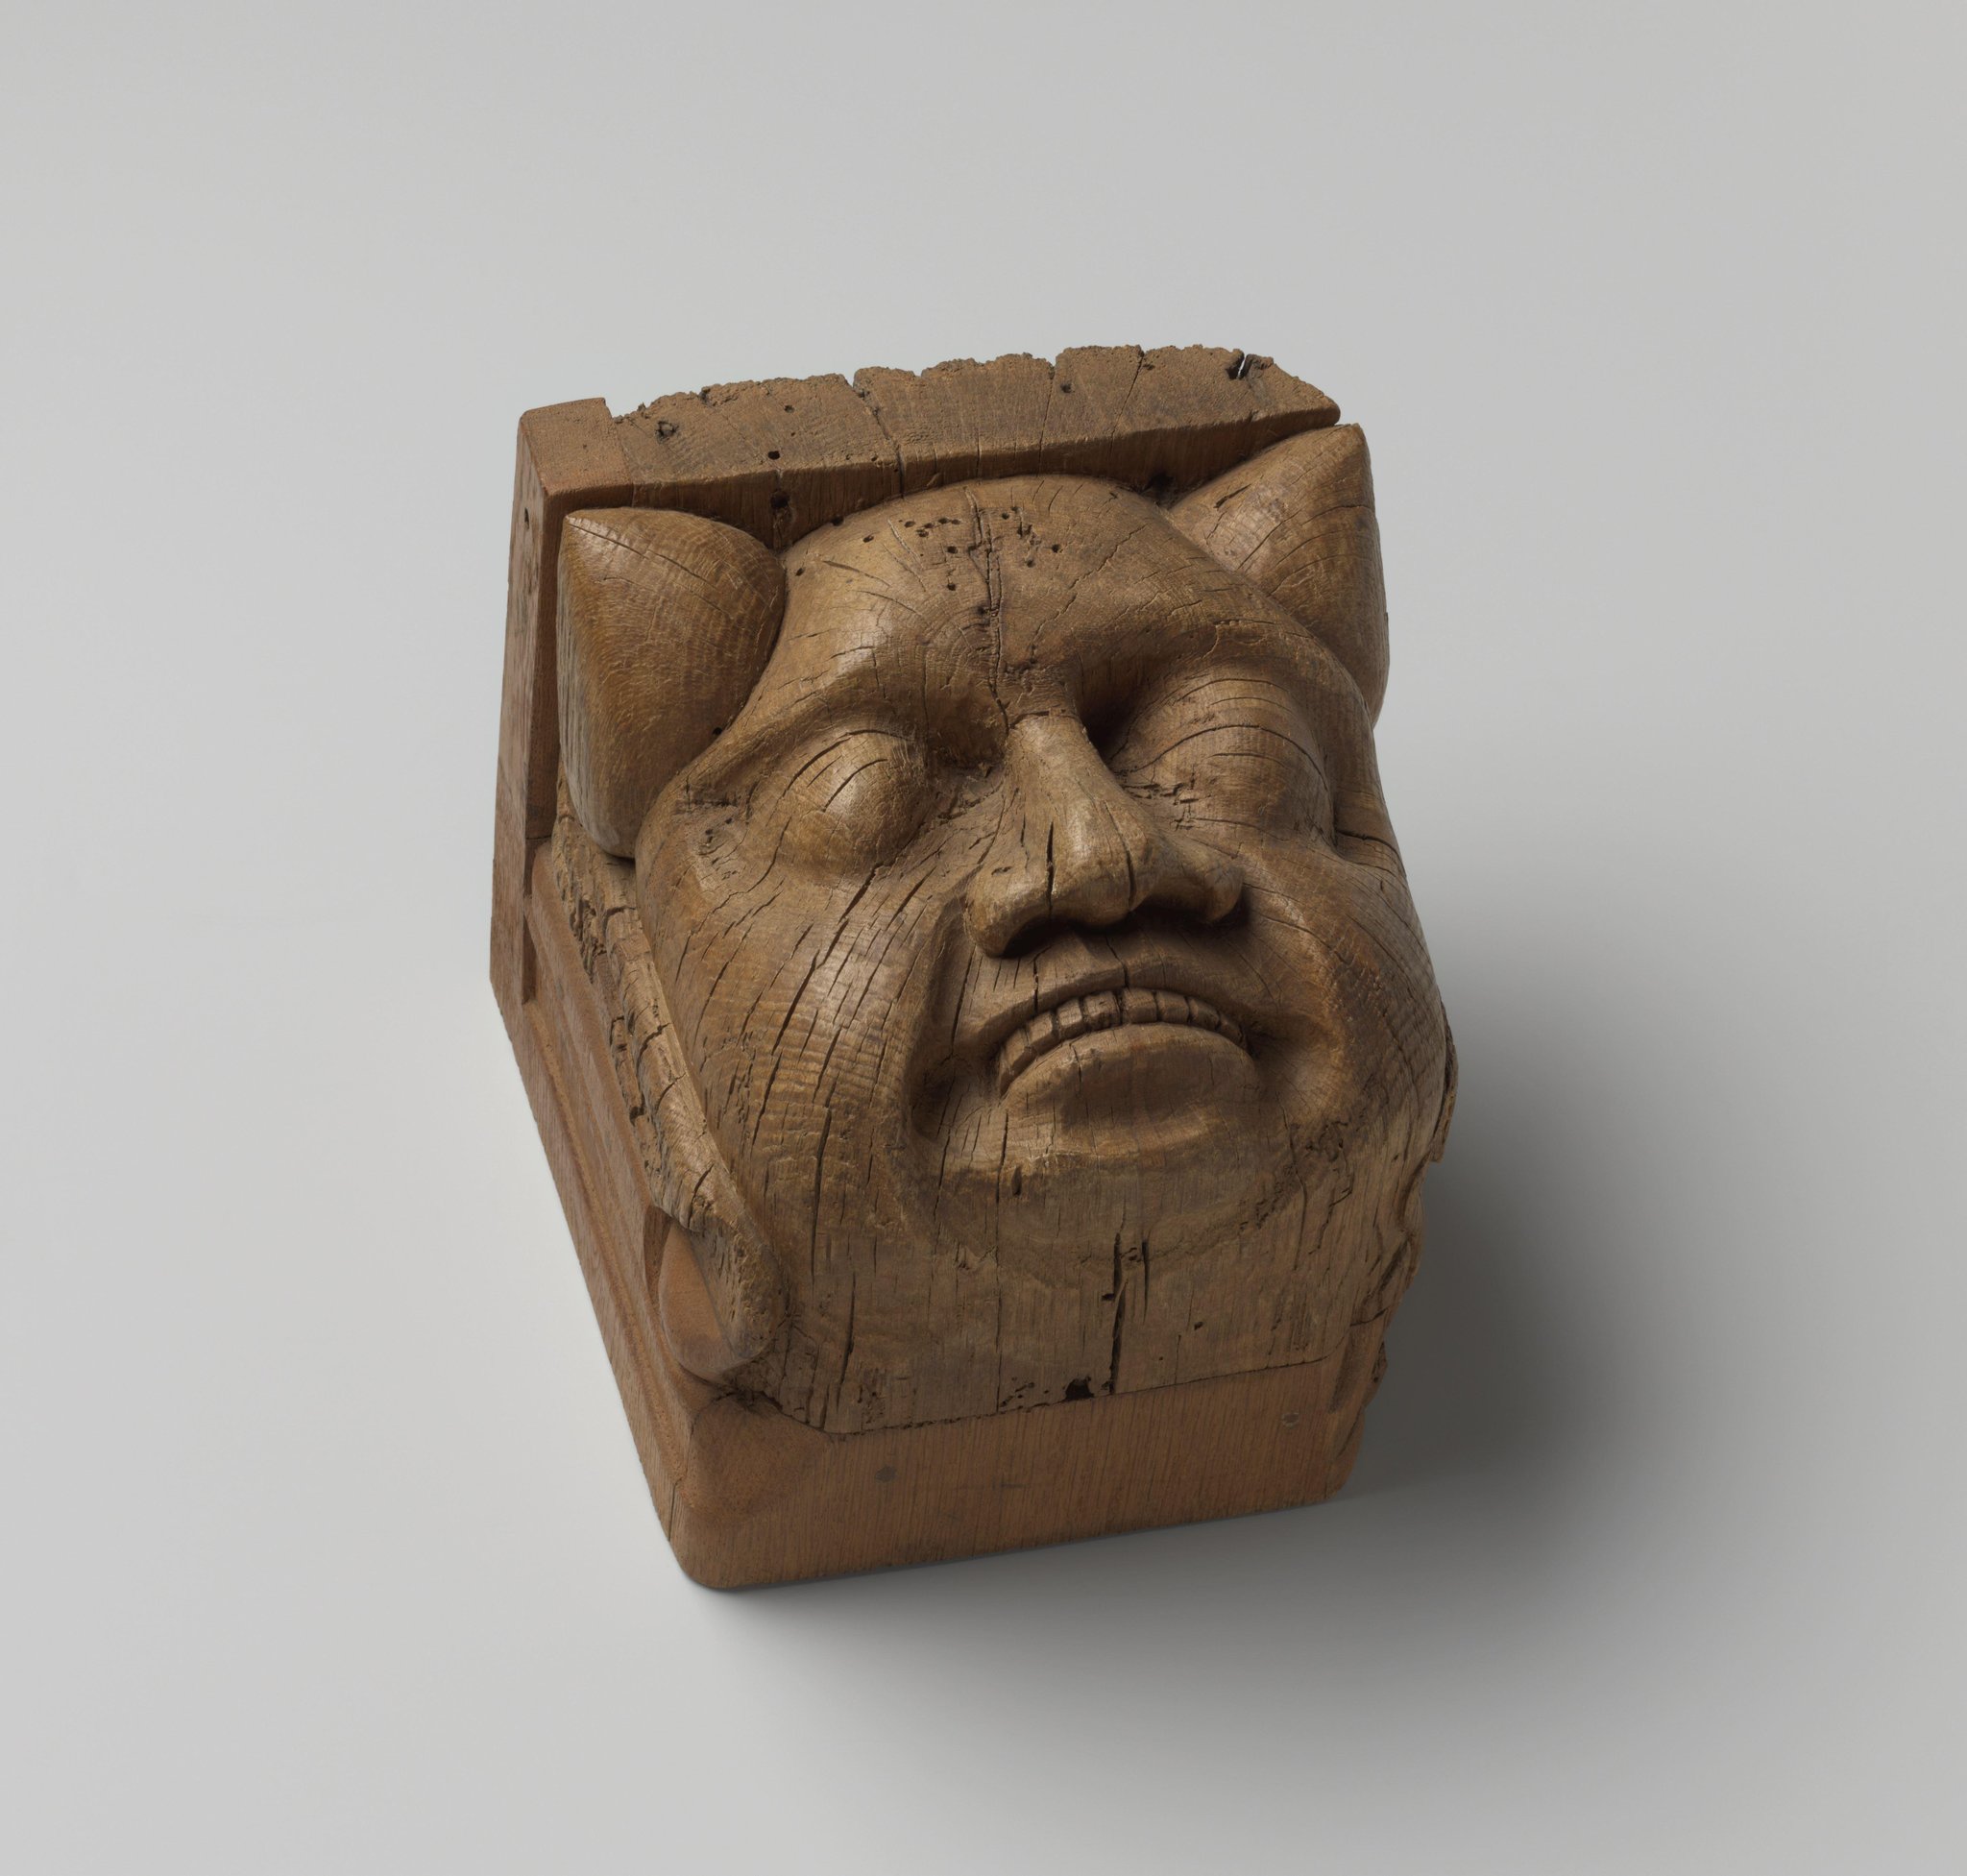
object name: korbeel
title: Bouwfragment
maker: Anonymous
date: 1400-1499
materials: wood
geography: northern netherlands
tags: rumpt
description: Kraagstuk van eikenhout of drager van een der muurstijlen van de kap over het koor van de kerk te Rumpt, voorstellende een grijnzende mannekop. Zie tevens: BK-NM-11080/11082.